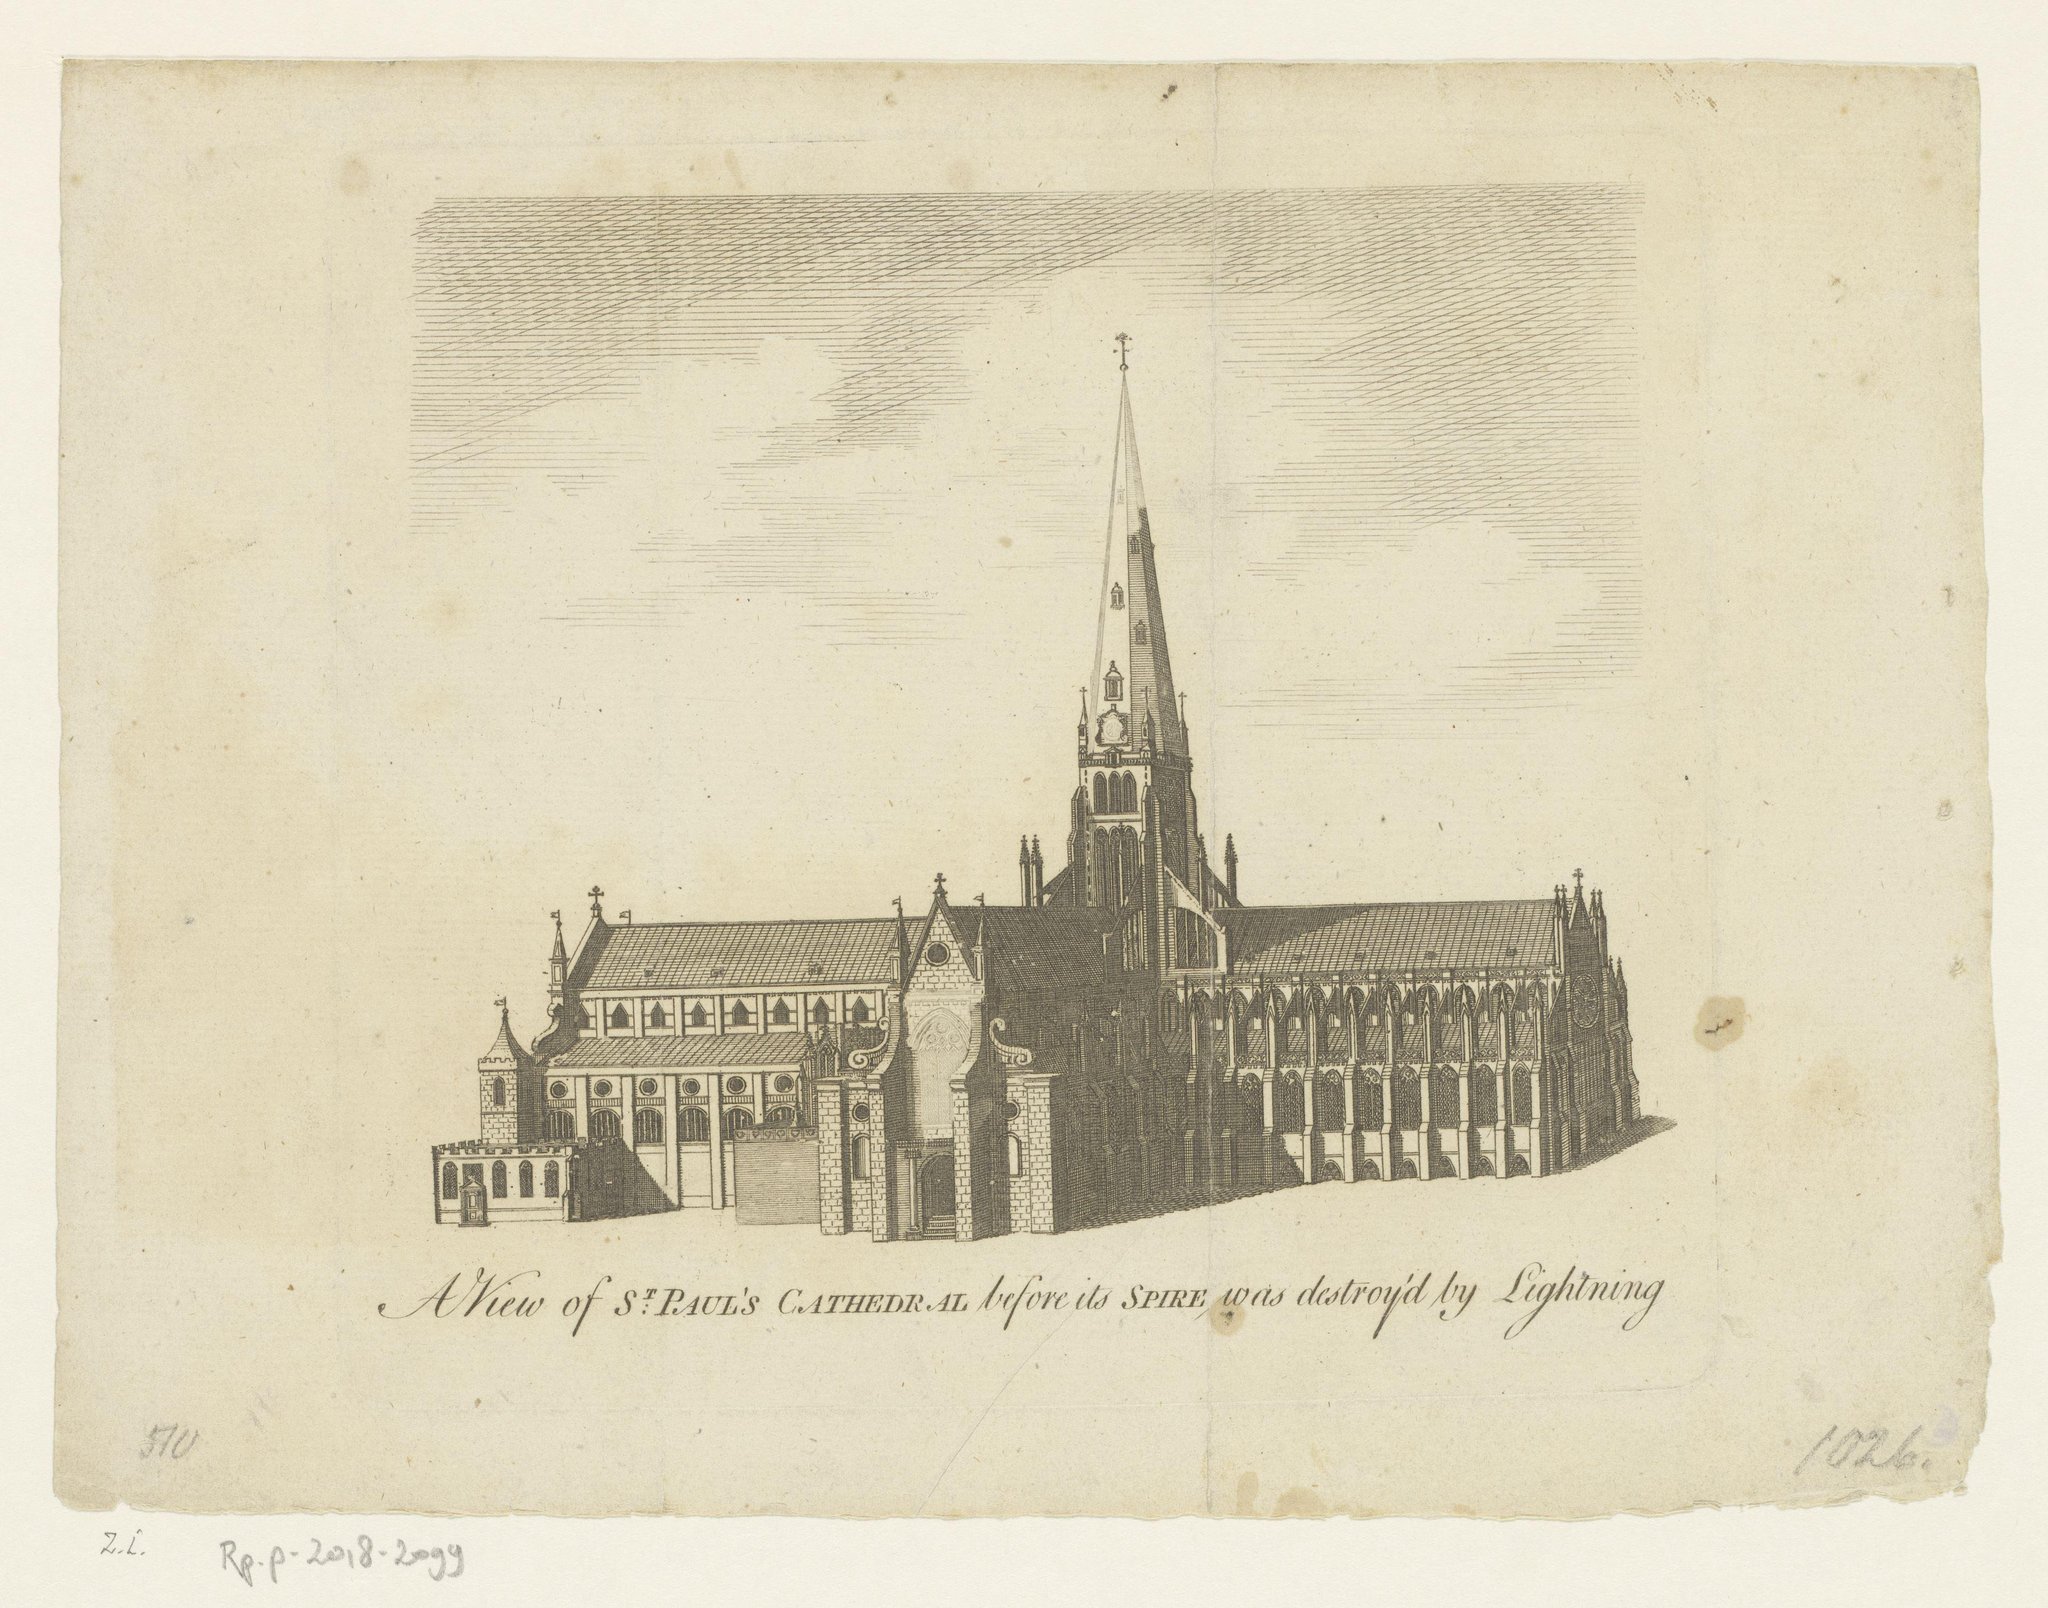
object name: print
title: A view of St. Paul's Cathedral before its spire was destroy'd by lightning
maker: Anonymous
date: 1700-1799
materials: paper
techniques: etching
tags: church (exterior)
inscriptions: collector's mark: Lugt 2228, collector's mark: Lugt 1337